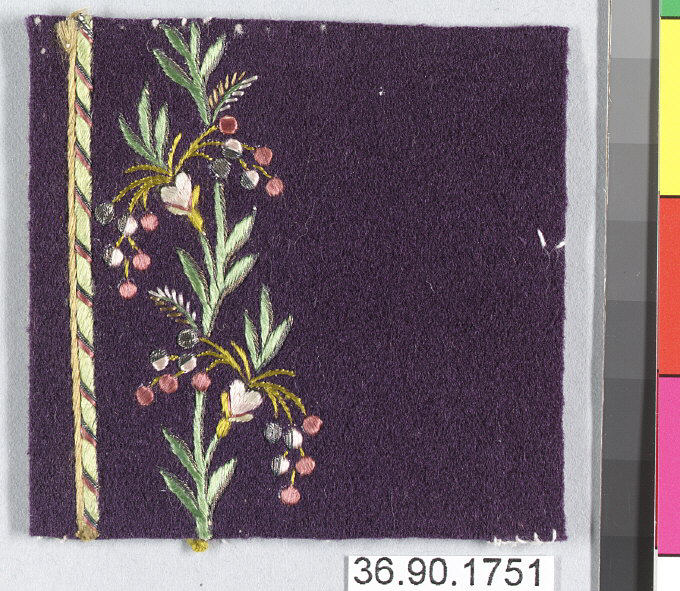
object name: sample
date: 1801-1833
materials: felt, metal thread, silk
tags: flowers